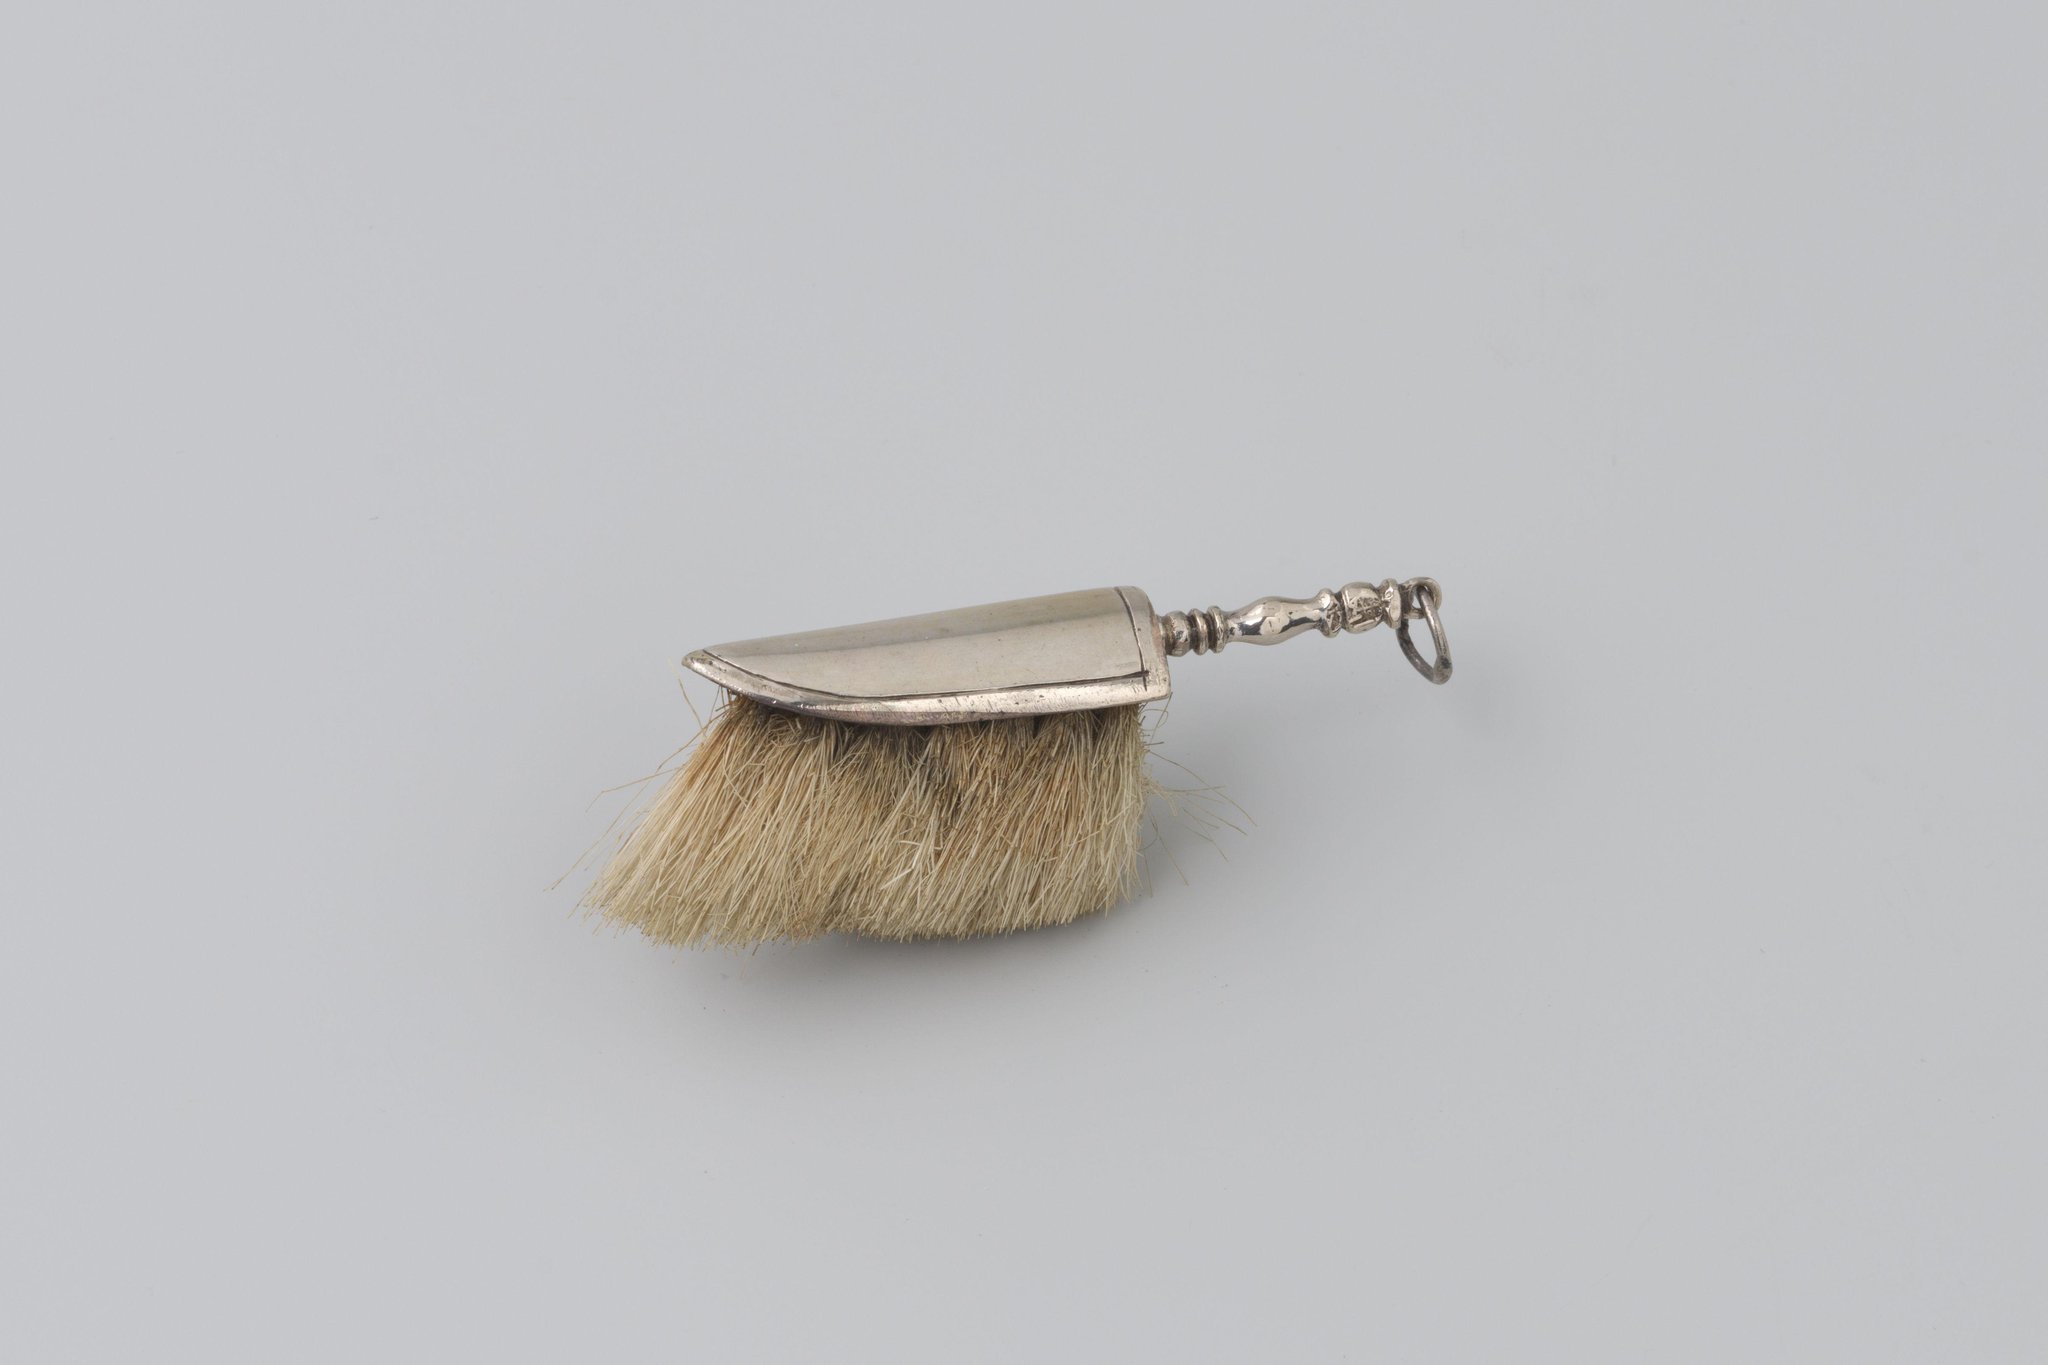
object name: whisk broom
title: Stoffer van zilver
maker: frederik van strant (i)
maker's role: silversmith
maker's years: 1678-1727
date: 1706-1727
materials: silver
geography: amsterdam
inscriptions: maker's mark: ‘FS (Citroen 1975, nr. 231)’, town mark: ‘kleine stadskeur Amsterdam’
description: Stoffer van zilver met varkenshaar, gladde, spits eindigende kop met groefrand, geprofileerde steel aan ring.